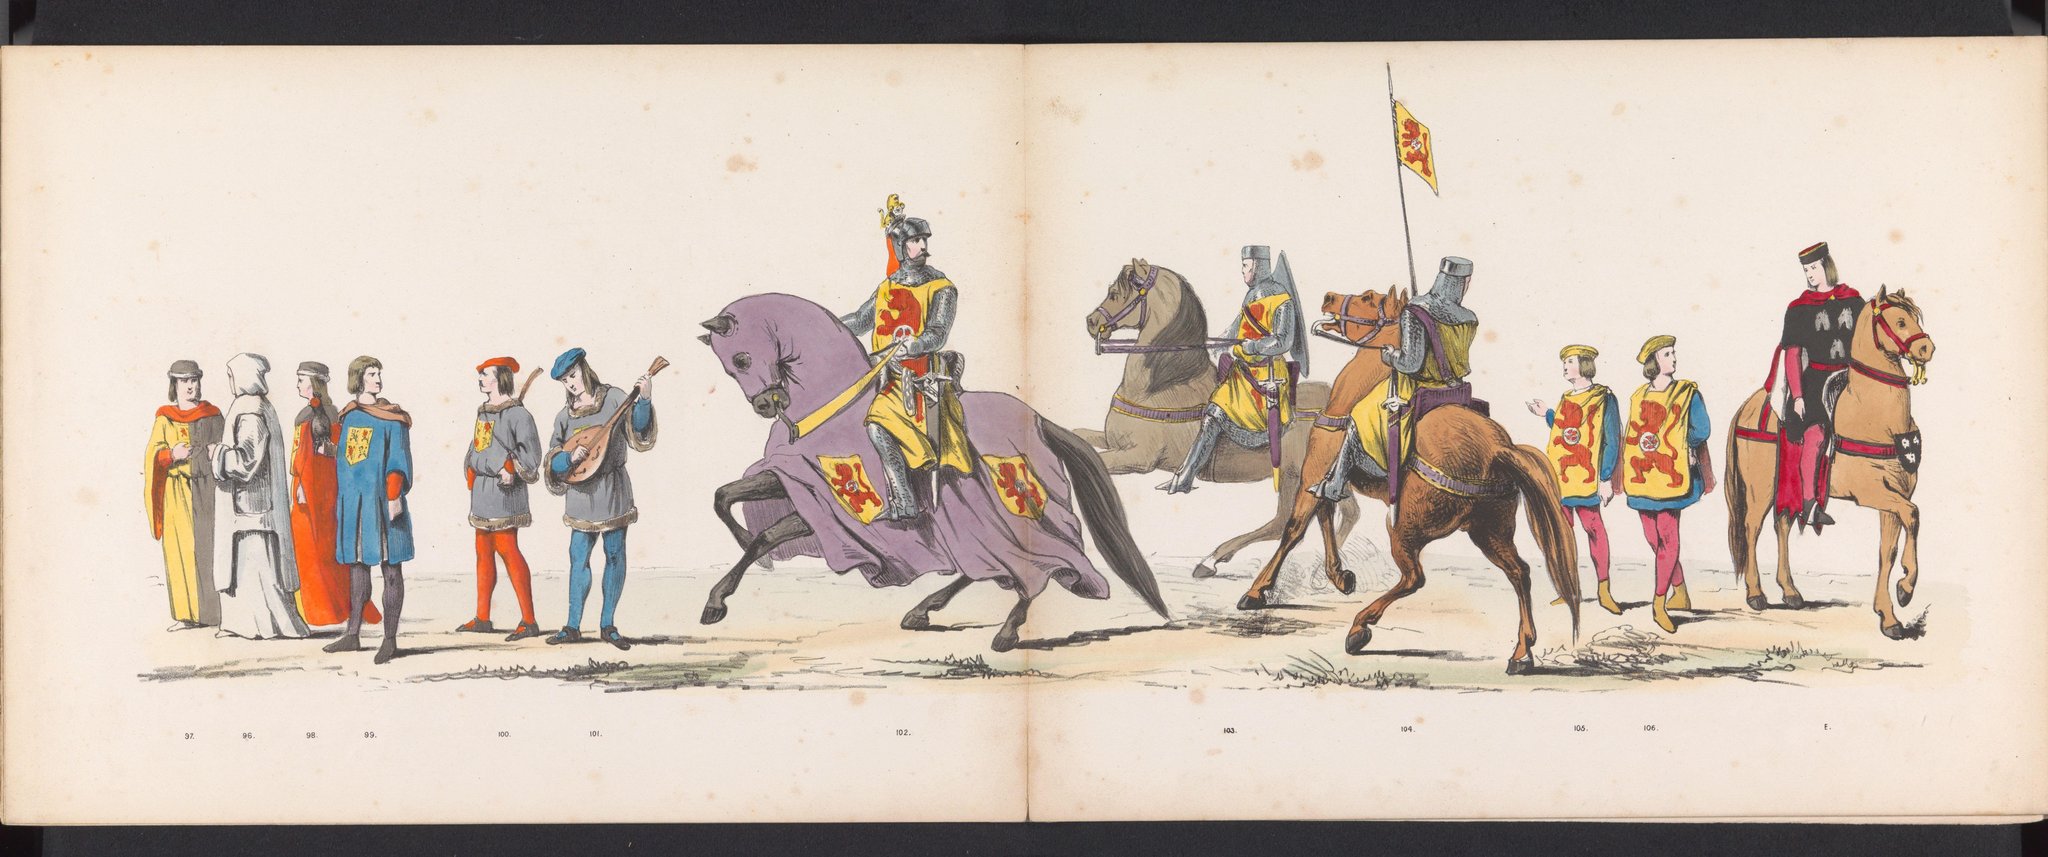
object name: print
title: Maskerade van de Leidse studenten, 1865 (plaat 8)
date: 1865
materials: paper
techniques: hand coloring, lithograph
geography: netherlands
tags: students' pageant, costumes used in pageants, leiden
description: Historische gekostumeerde optocht van de studenten van de Leidse Hogeschool gehouden op 6 juni 1865 ter gelegenheid van het 290-jarig bestaan van de Hogeschool. De optocht verbeeldt de intocht van de Hollanders binnen Zierikzee op 12 augustus 1304. Achtste plaat met de groepen genummerd 97-106. Onderdeel van de serie van 16 aaneen geplakte bladen.